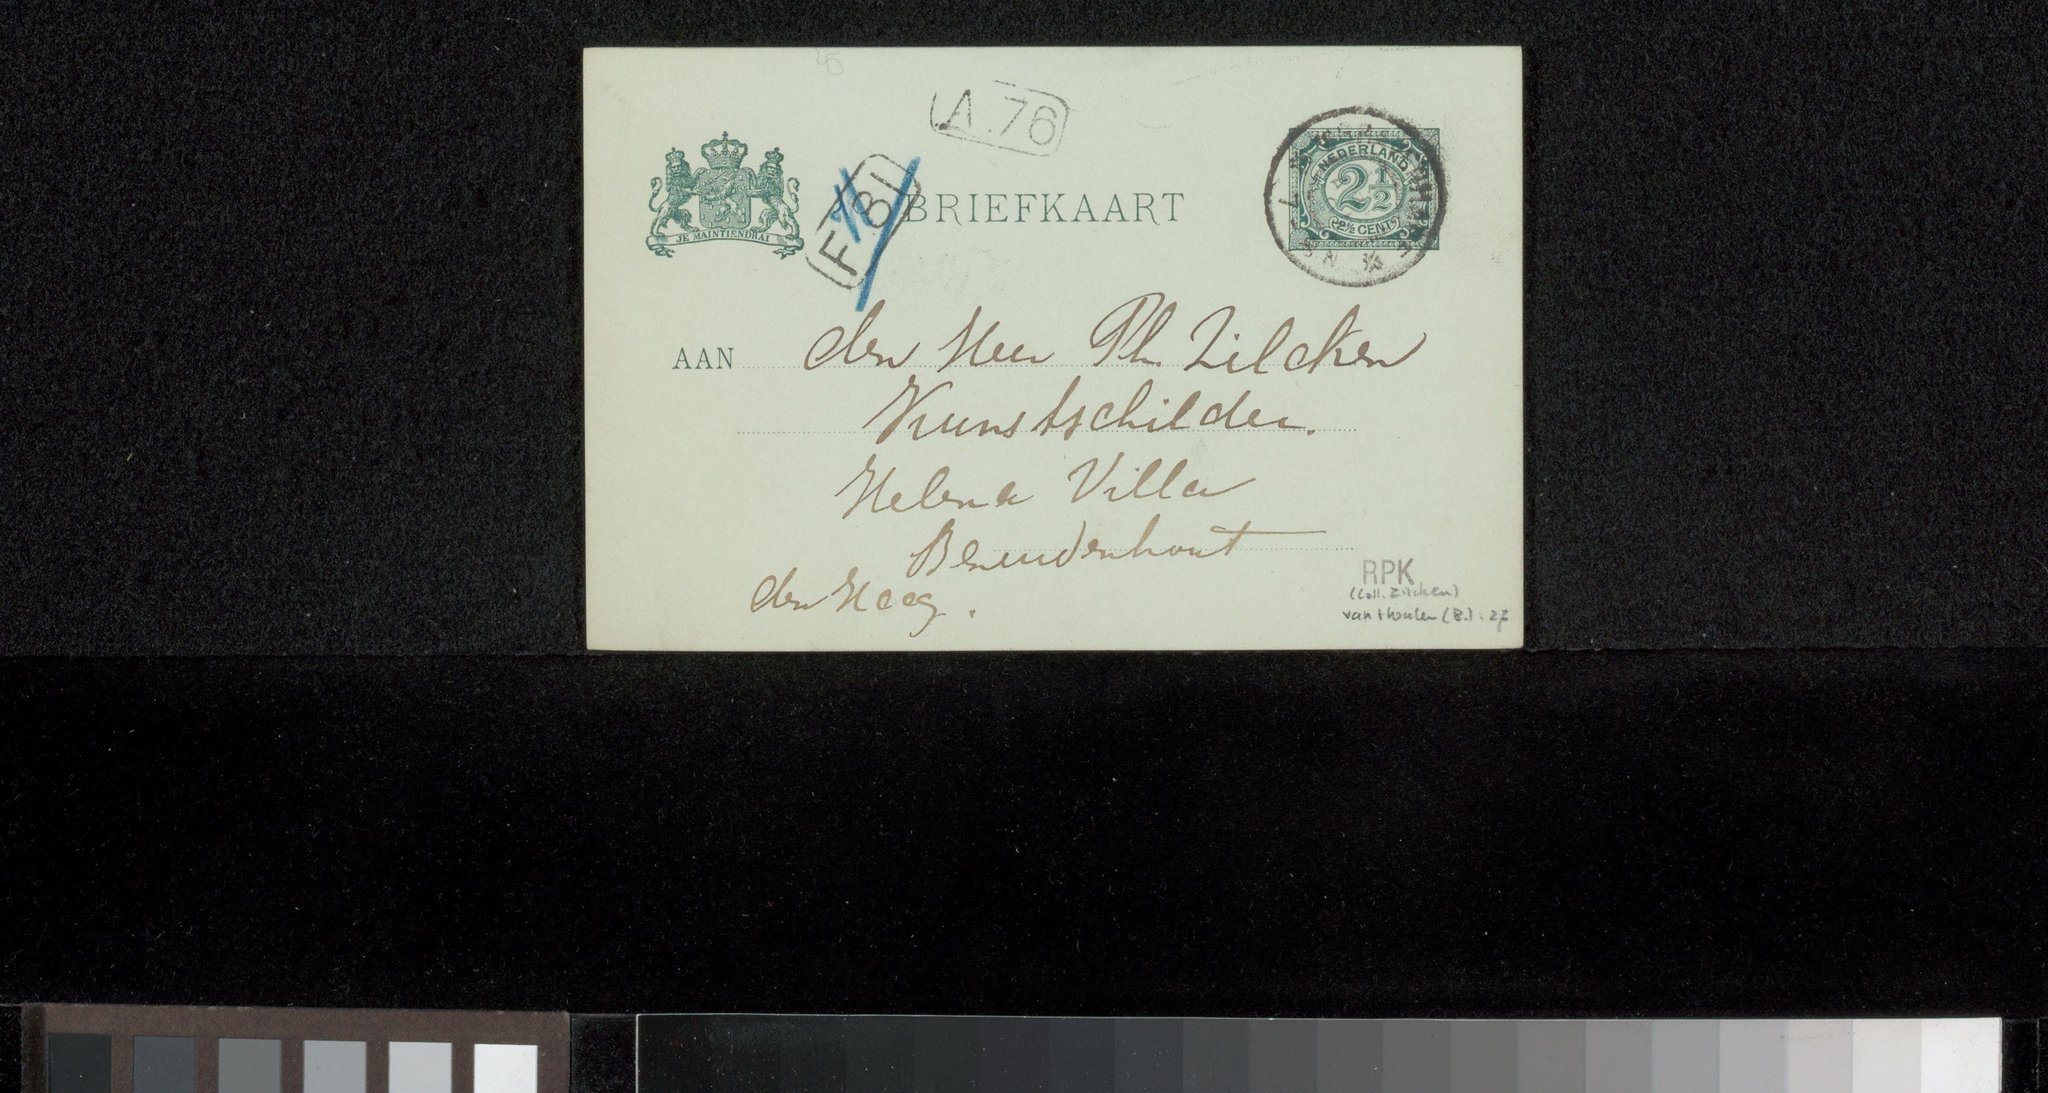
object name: postcard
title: Briefkaart aan Philip Zilcken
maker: barbara elisabeth van houten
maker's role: draughtsman, print maker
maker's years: 1862-1950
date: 1872-1930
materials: cardboard, ink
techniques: pen, writing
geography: the hague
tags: painter, draughtsman, philip zilcken, sending and receiving postal matter, the graphic arts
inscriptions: collector's mark: ‘RPK’